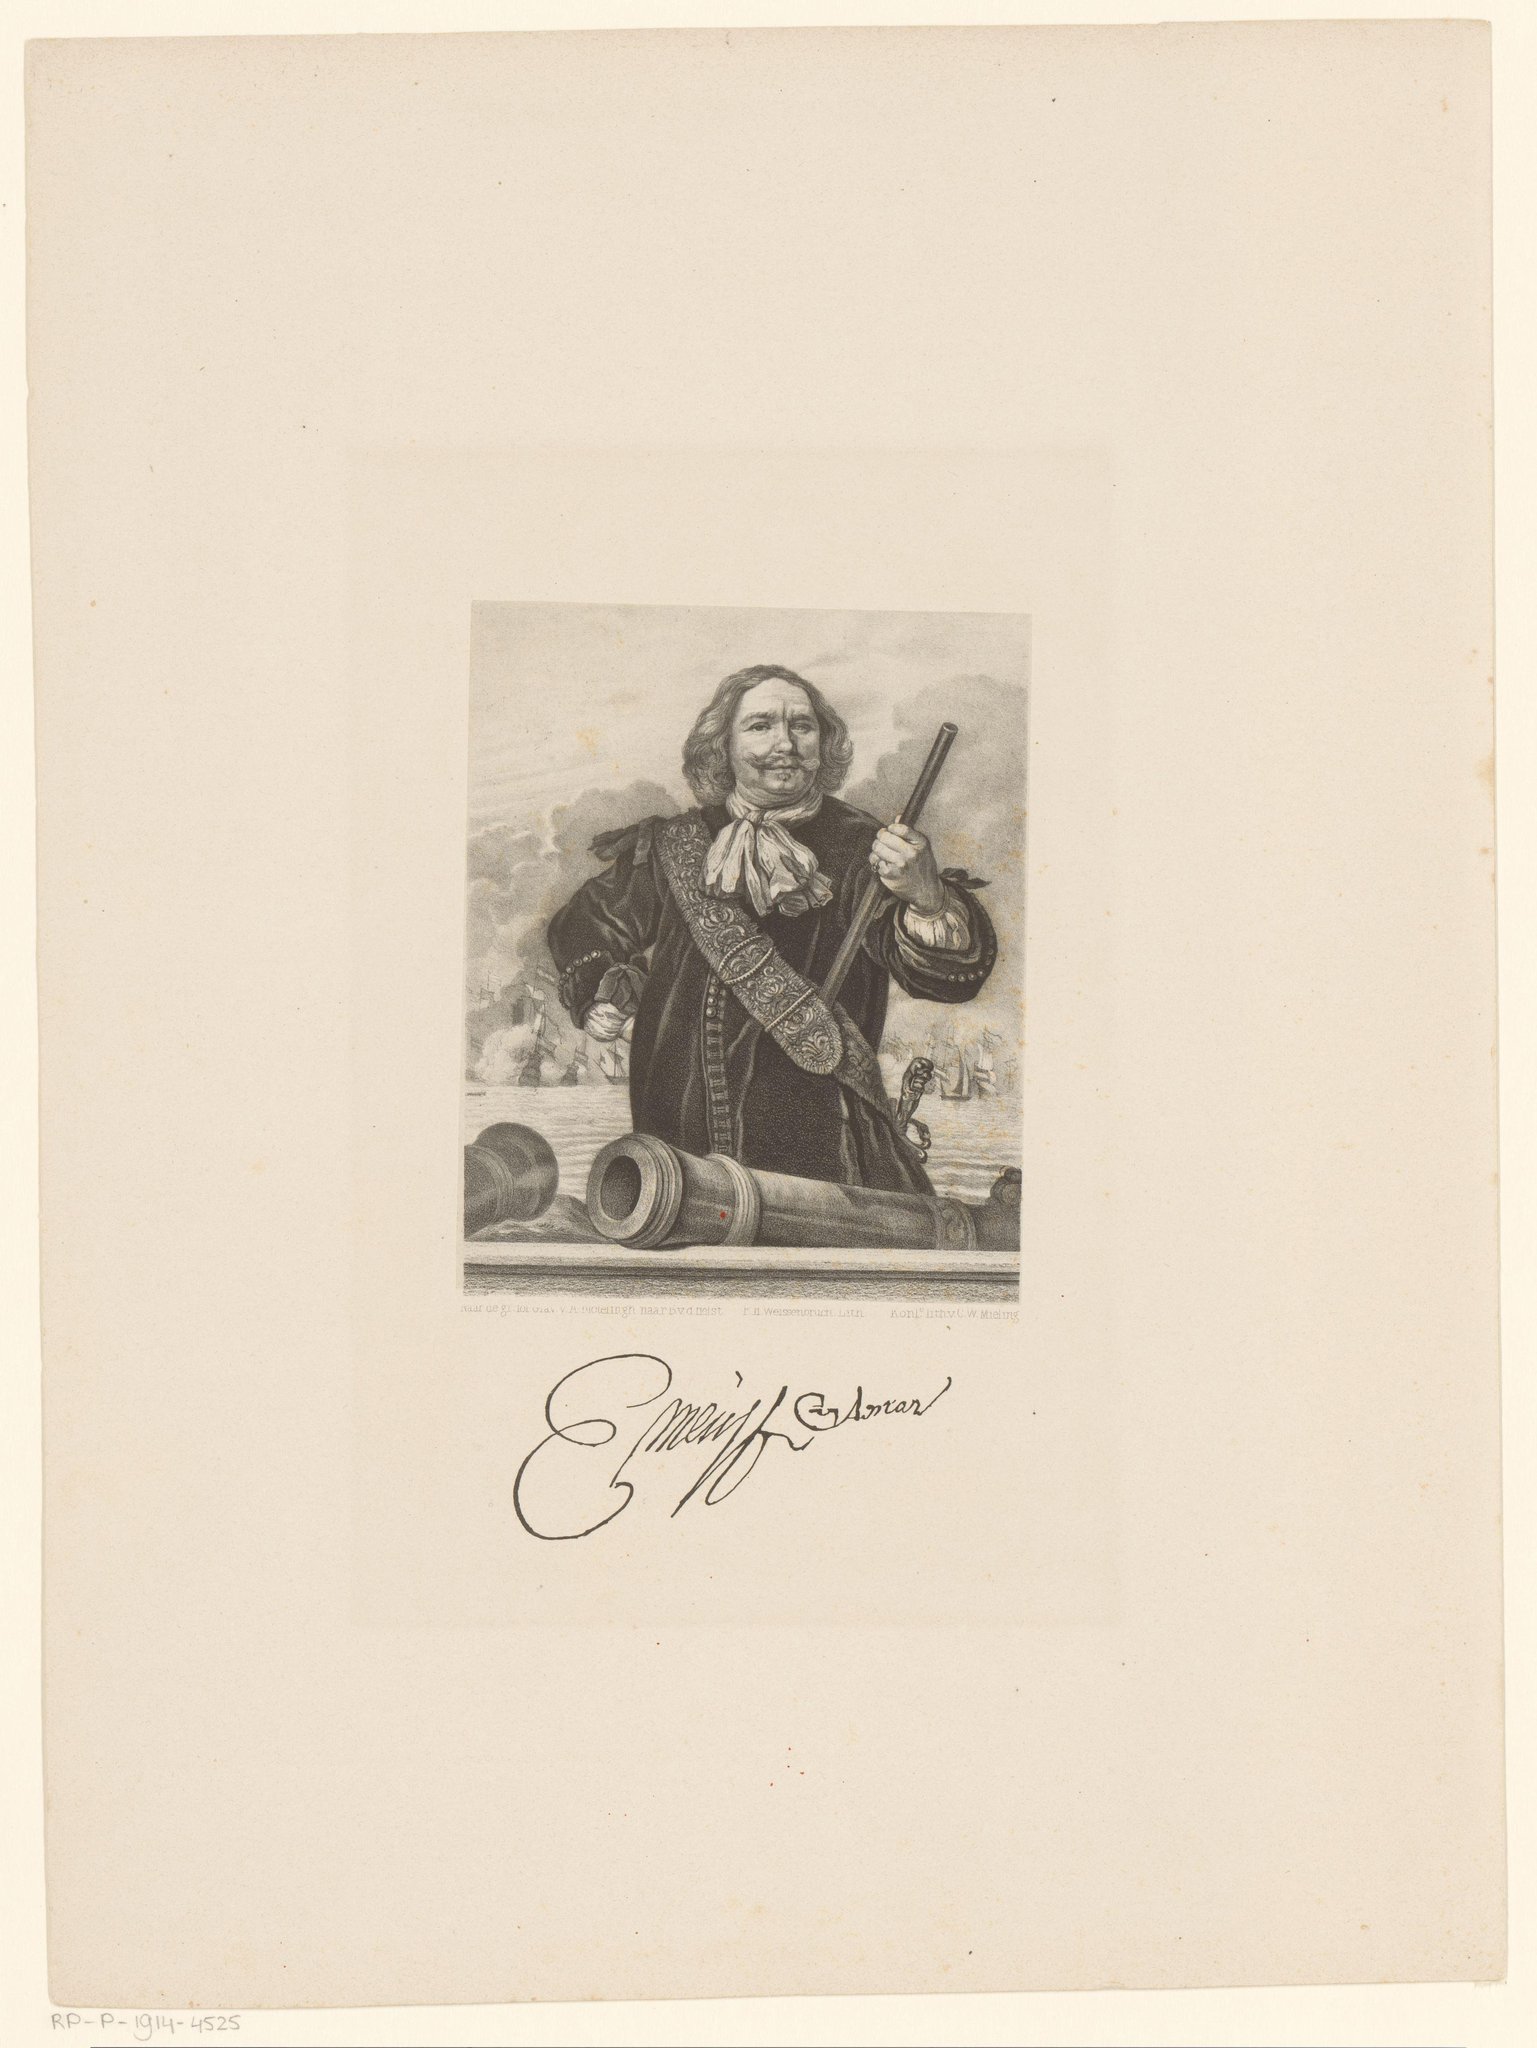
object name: book illustration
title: Portret van Egbert Meeusz Kortenaer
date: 1858-1862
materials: paper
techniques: lithograph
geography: the hague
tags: historical persons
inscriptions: collector's mark: Lugt 2228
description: Prent uit: Jonge, J.C. de. Geschiedenis van het Nederlandsche zeewezen. Haarlem: Jonge, J.K.J. de, 1858-62.